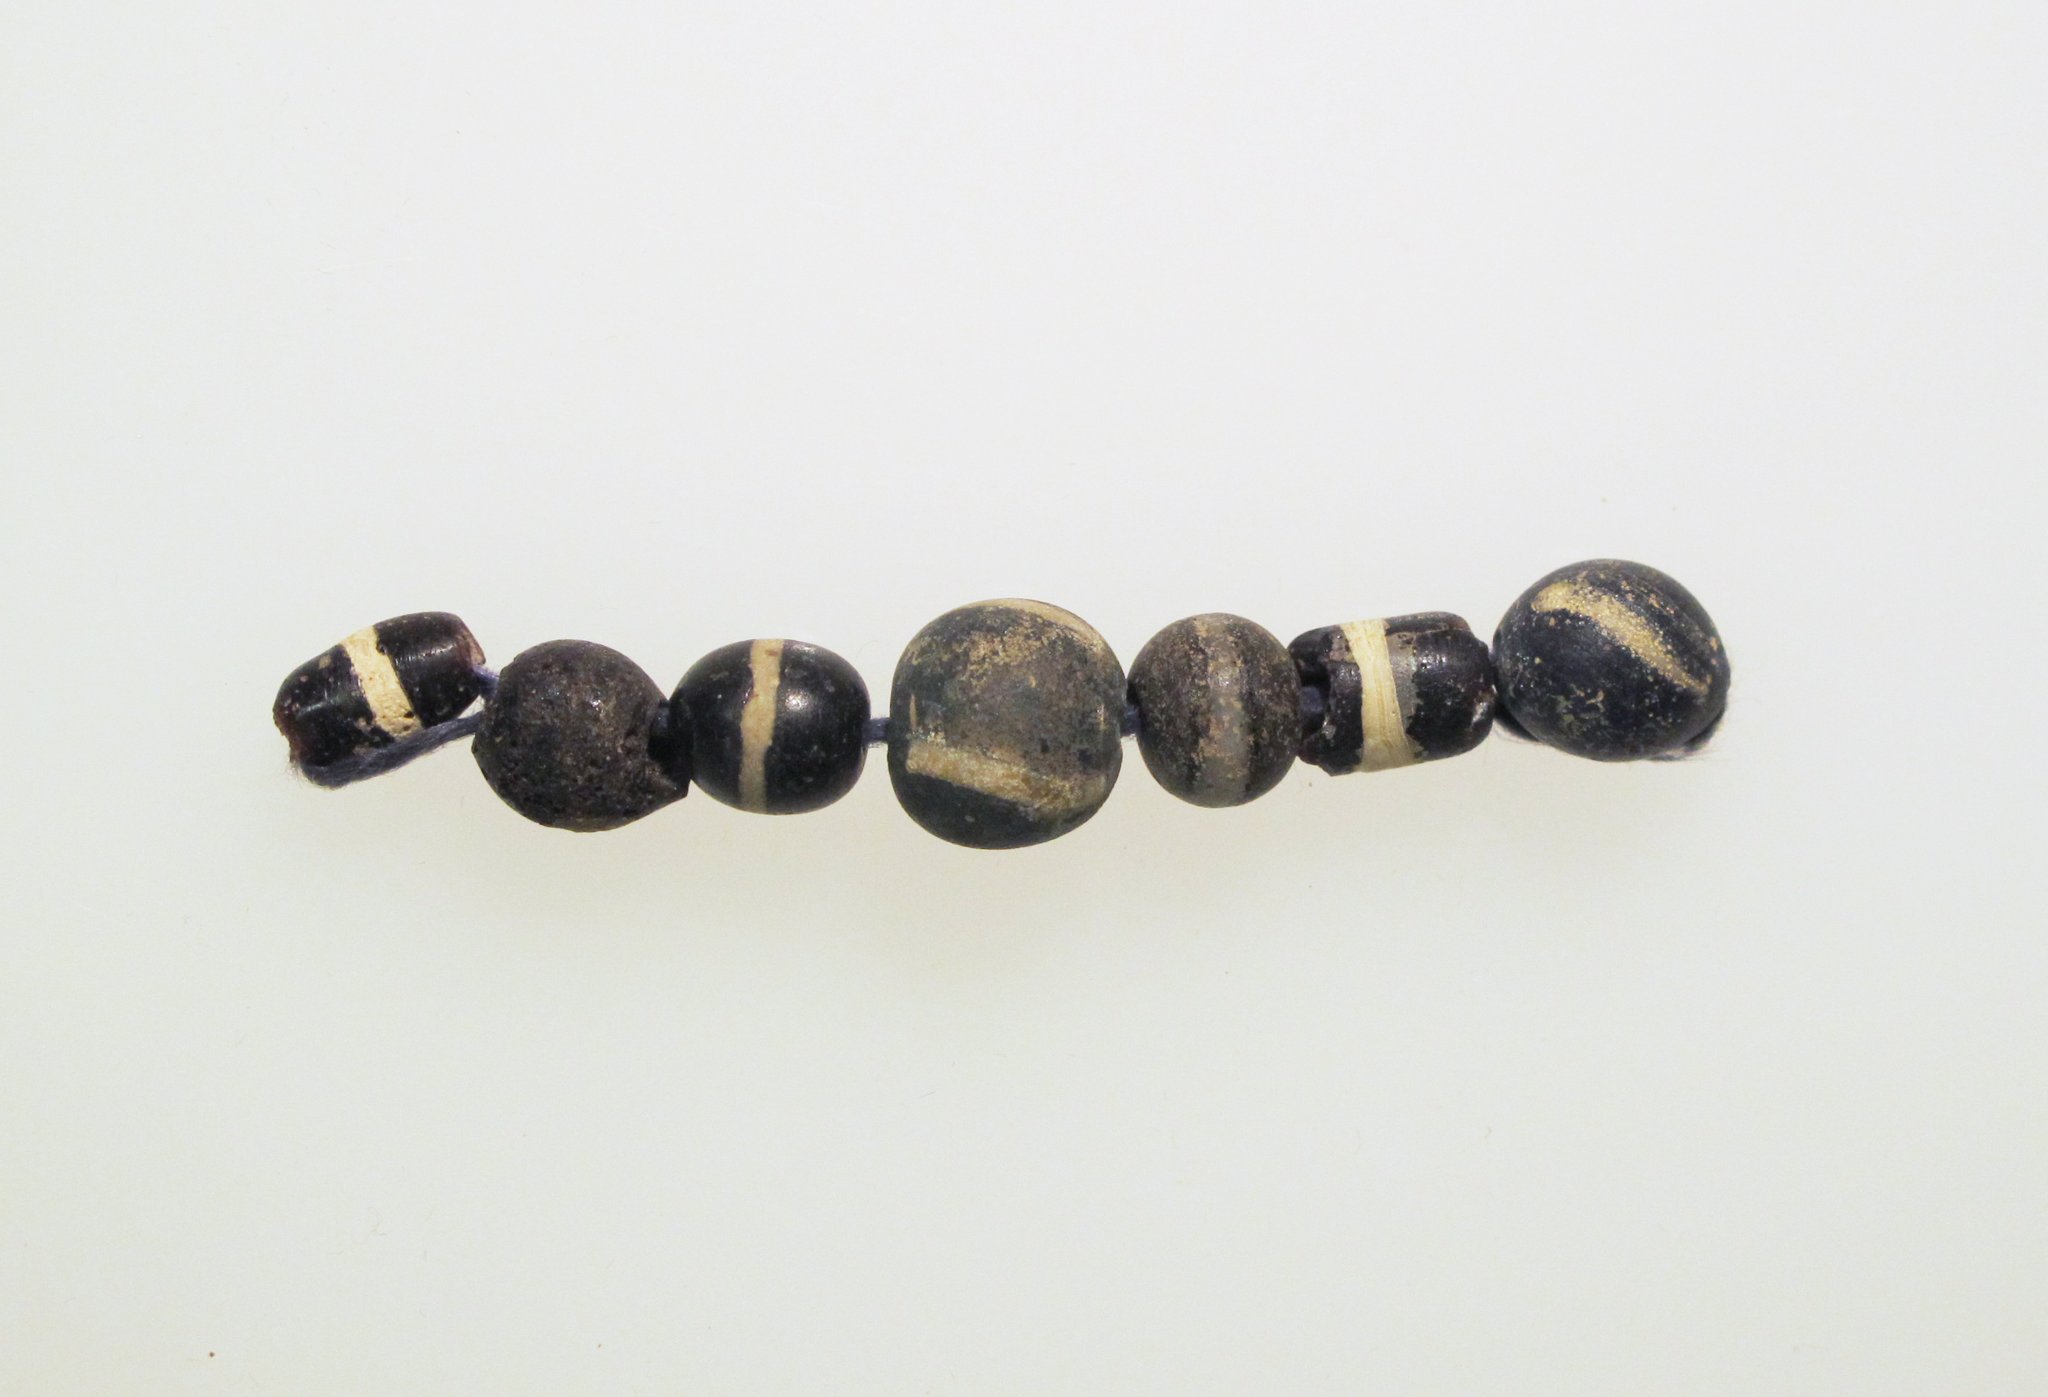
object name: bead, 7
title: Beads, 7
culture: roman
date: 670 BCE-330 CE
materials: glass